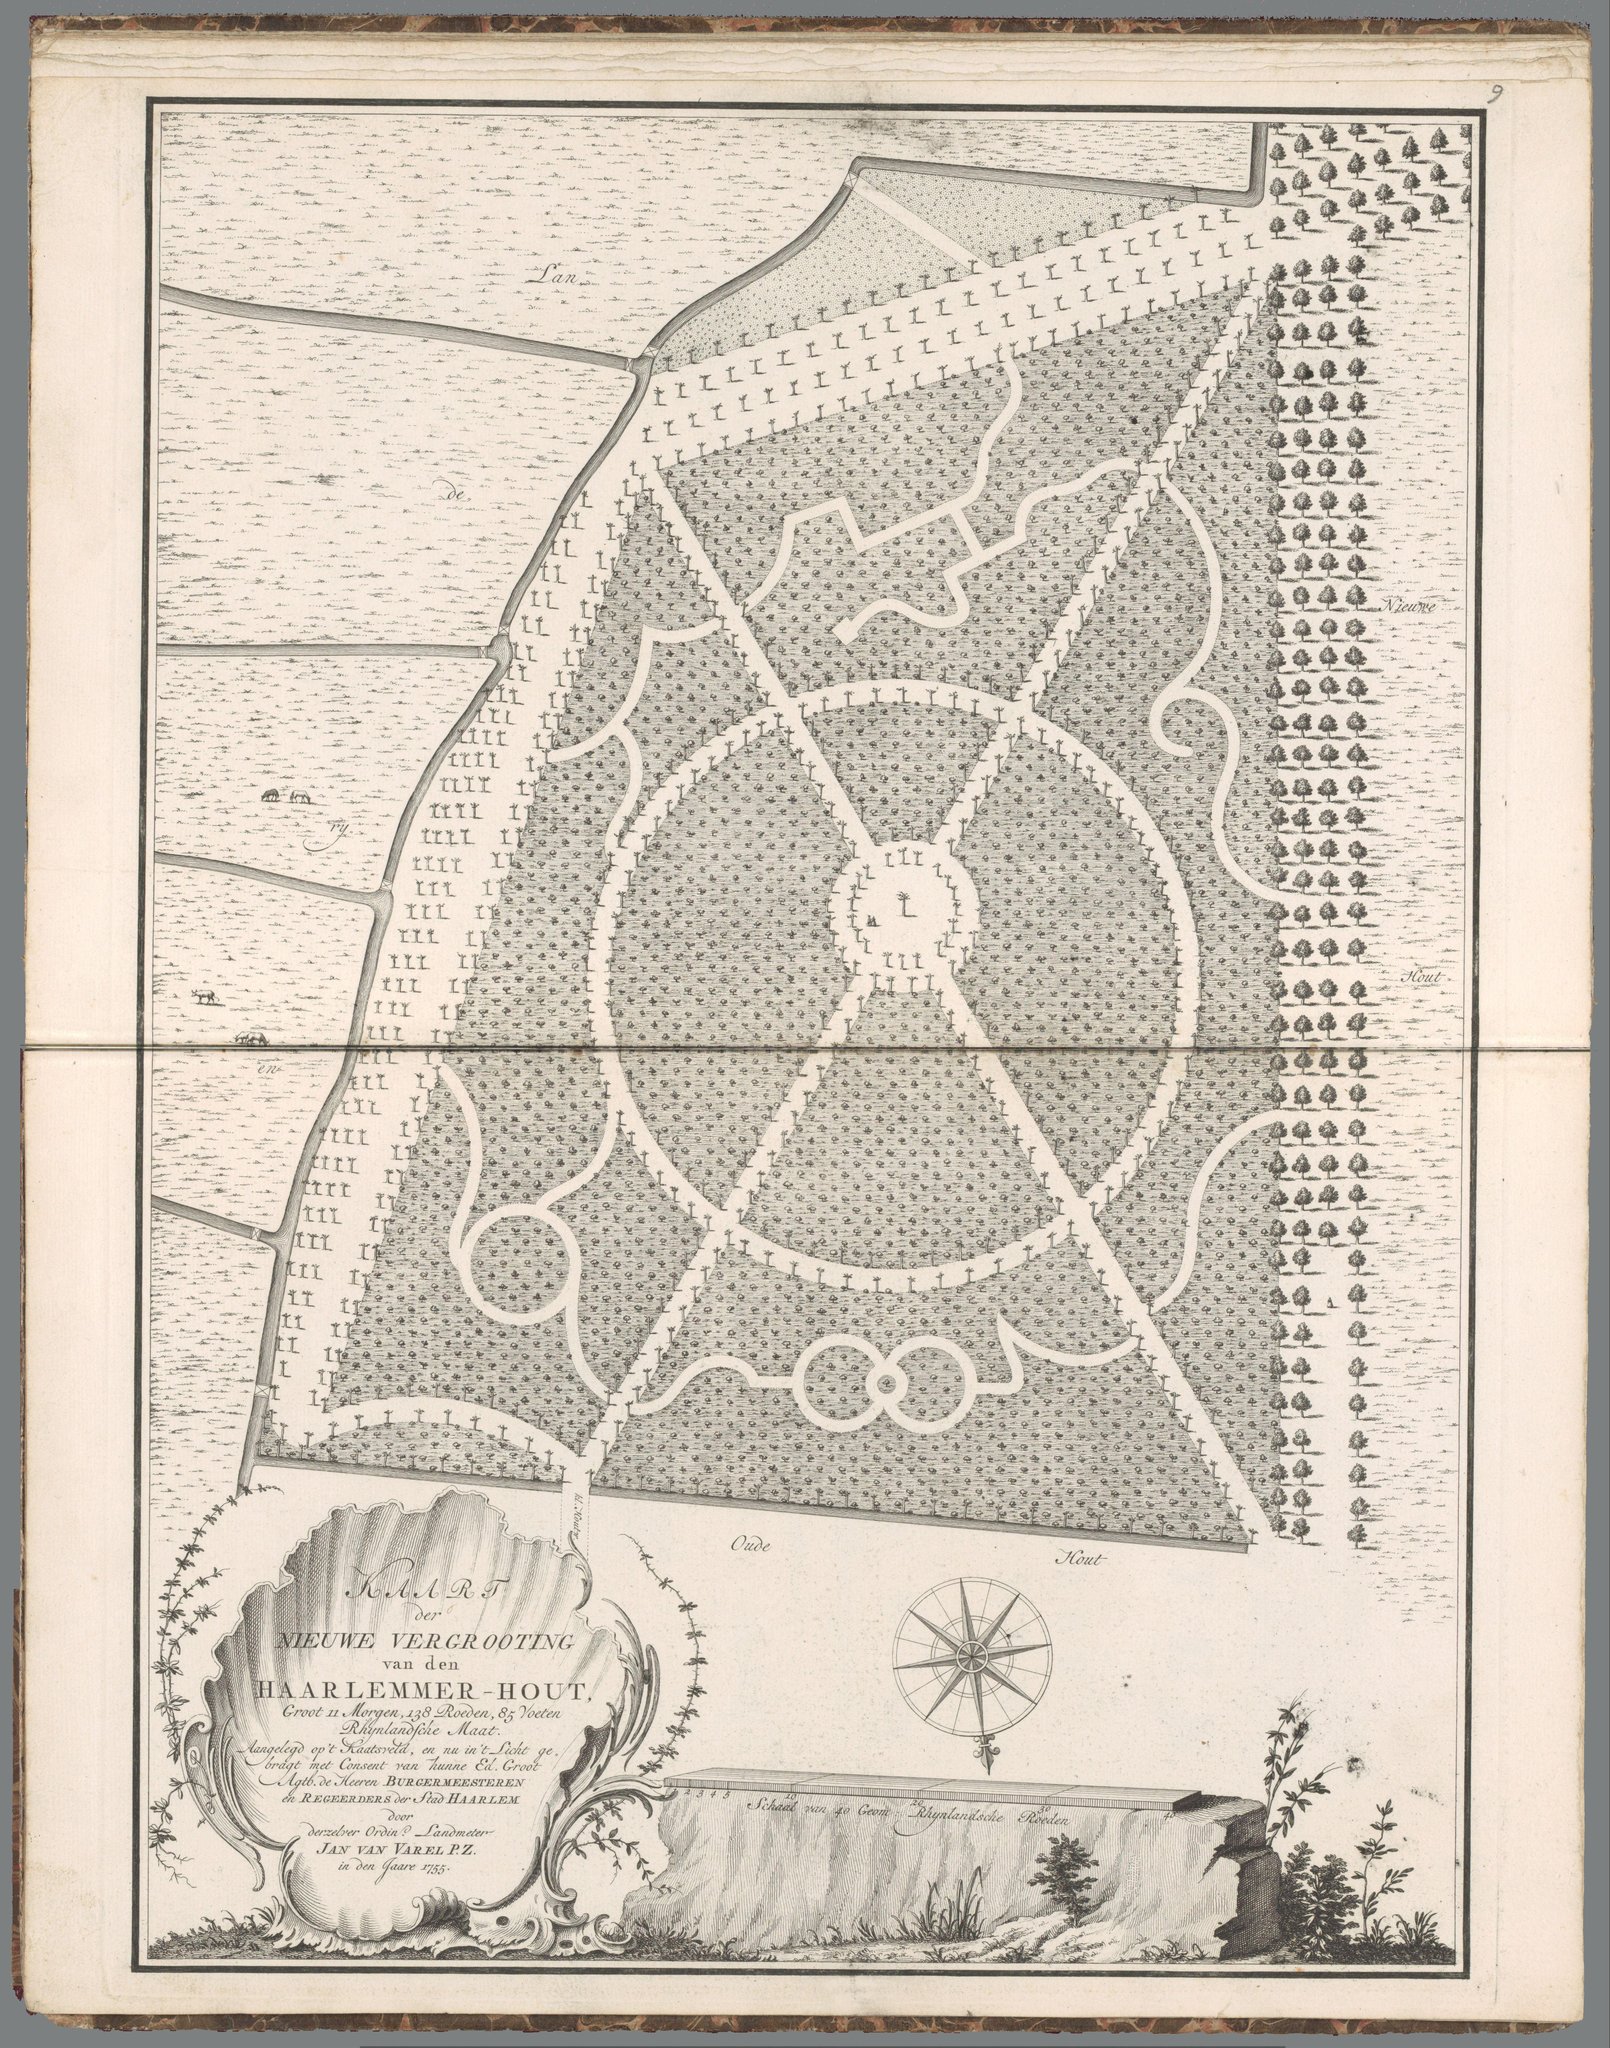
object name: album leaf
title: Kaart der Nieuwe Vergrooting van den Haarlemmer-Hout (...)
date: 1755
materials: paper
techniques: engraving, etching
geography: haarlem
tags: park, maps, atlases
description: Plattegrond van de uitbreiding van de Haarlemmerhout. Onderaan een ornamentele schelp met tekst en een schaalverdeling. Deze prent maakt deel uit van een album.